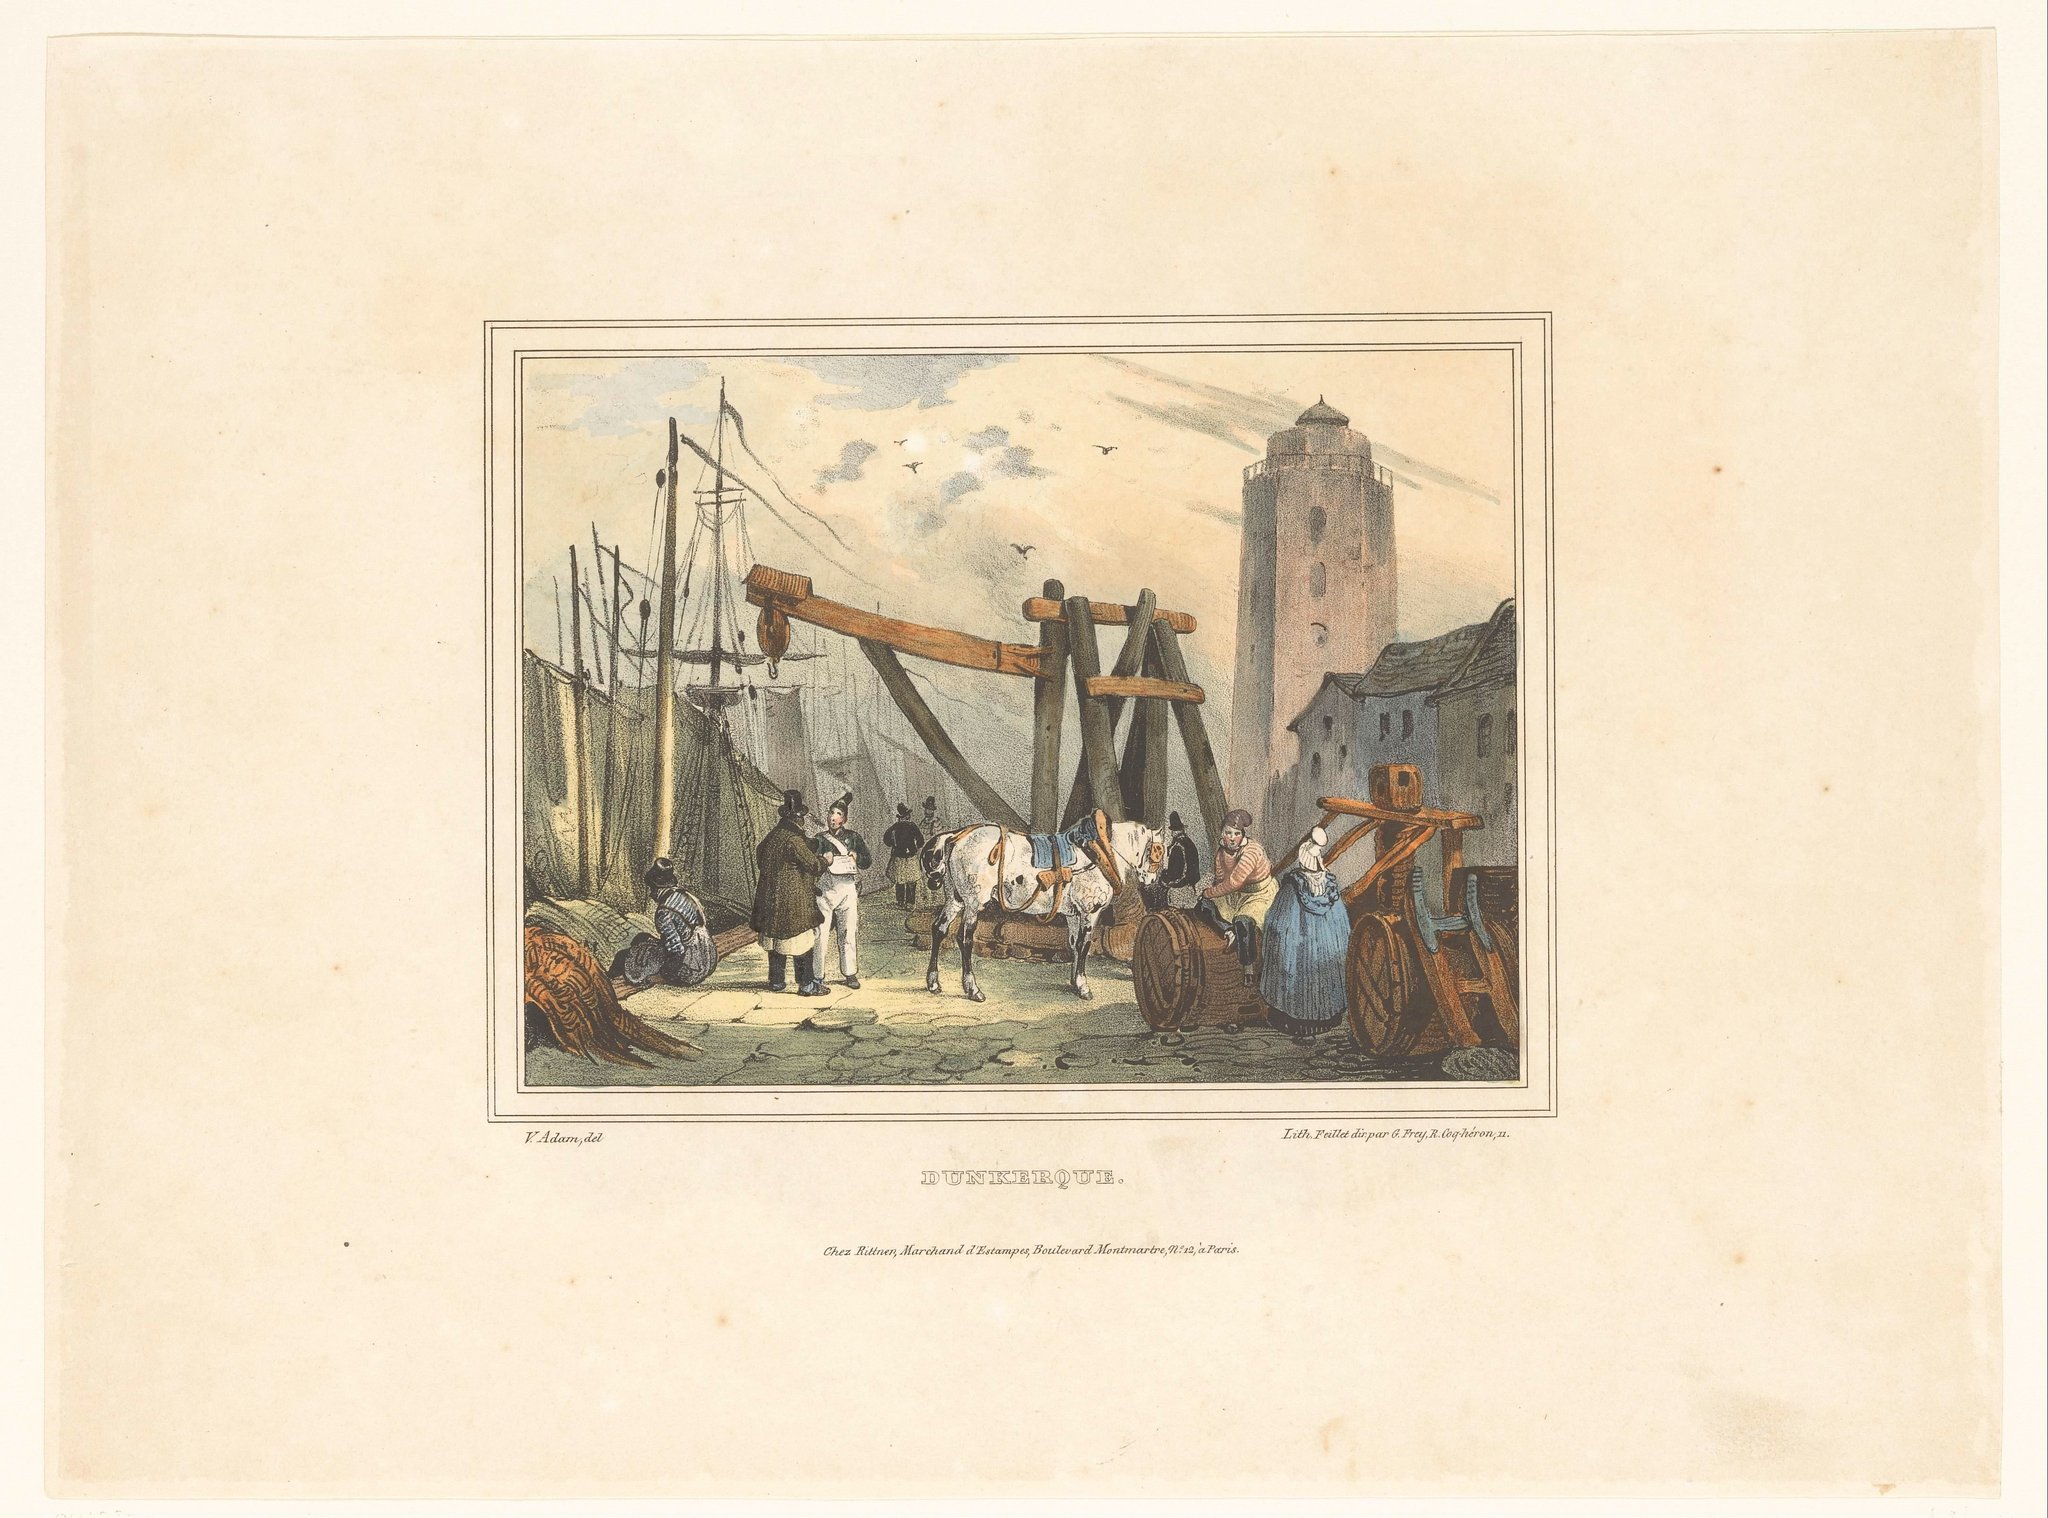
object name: print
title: Haven van Duinkerken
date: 1827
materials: paper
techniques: hand coloring, lithograph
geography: paris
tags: ships (in general), folk costume, regional costume, coast (+ landscape with figures, staffage)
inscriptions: collector's mark: Lugt 2228